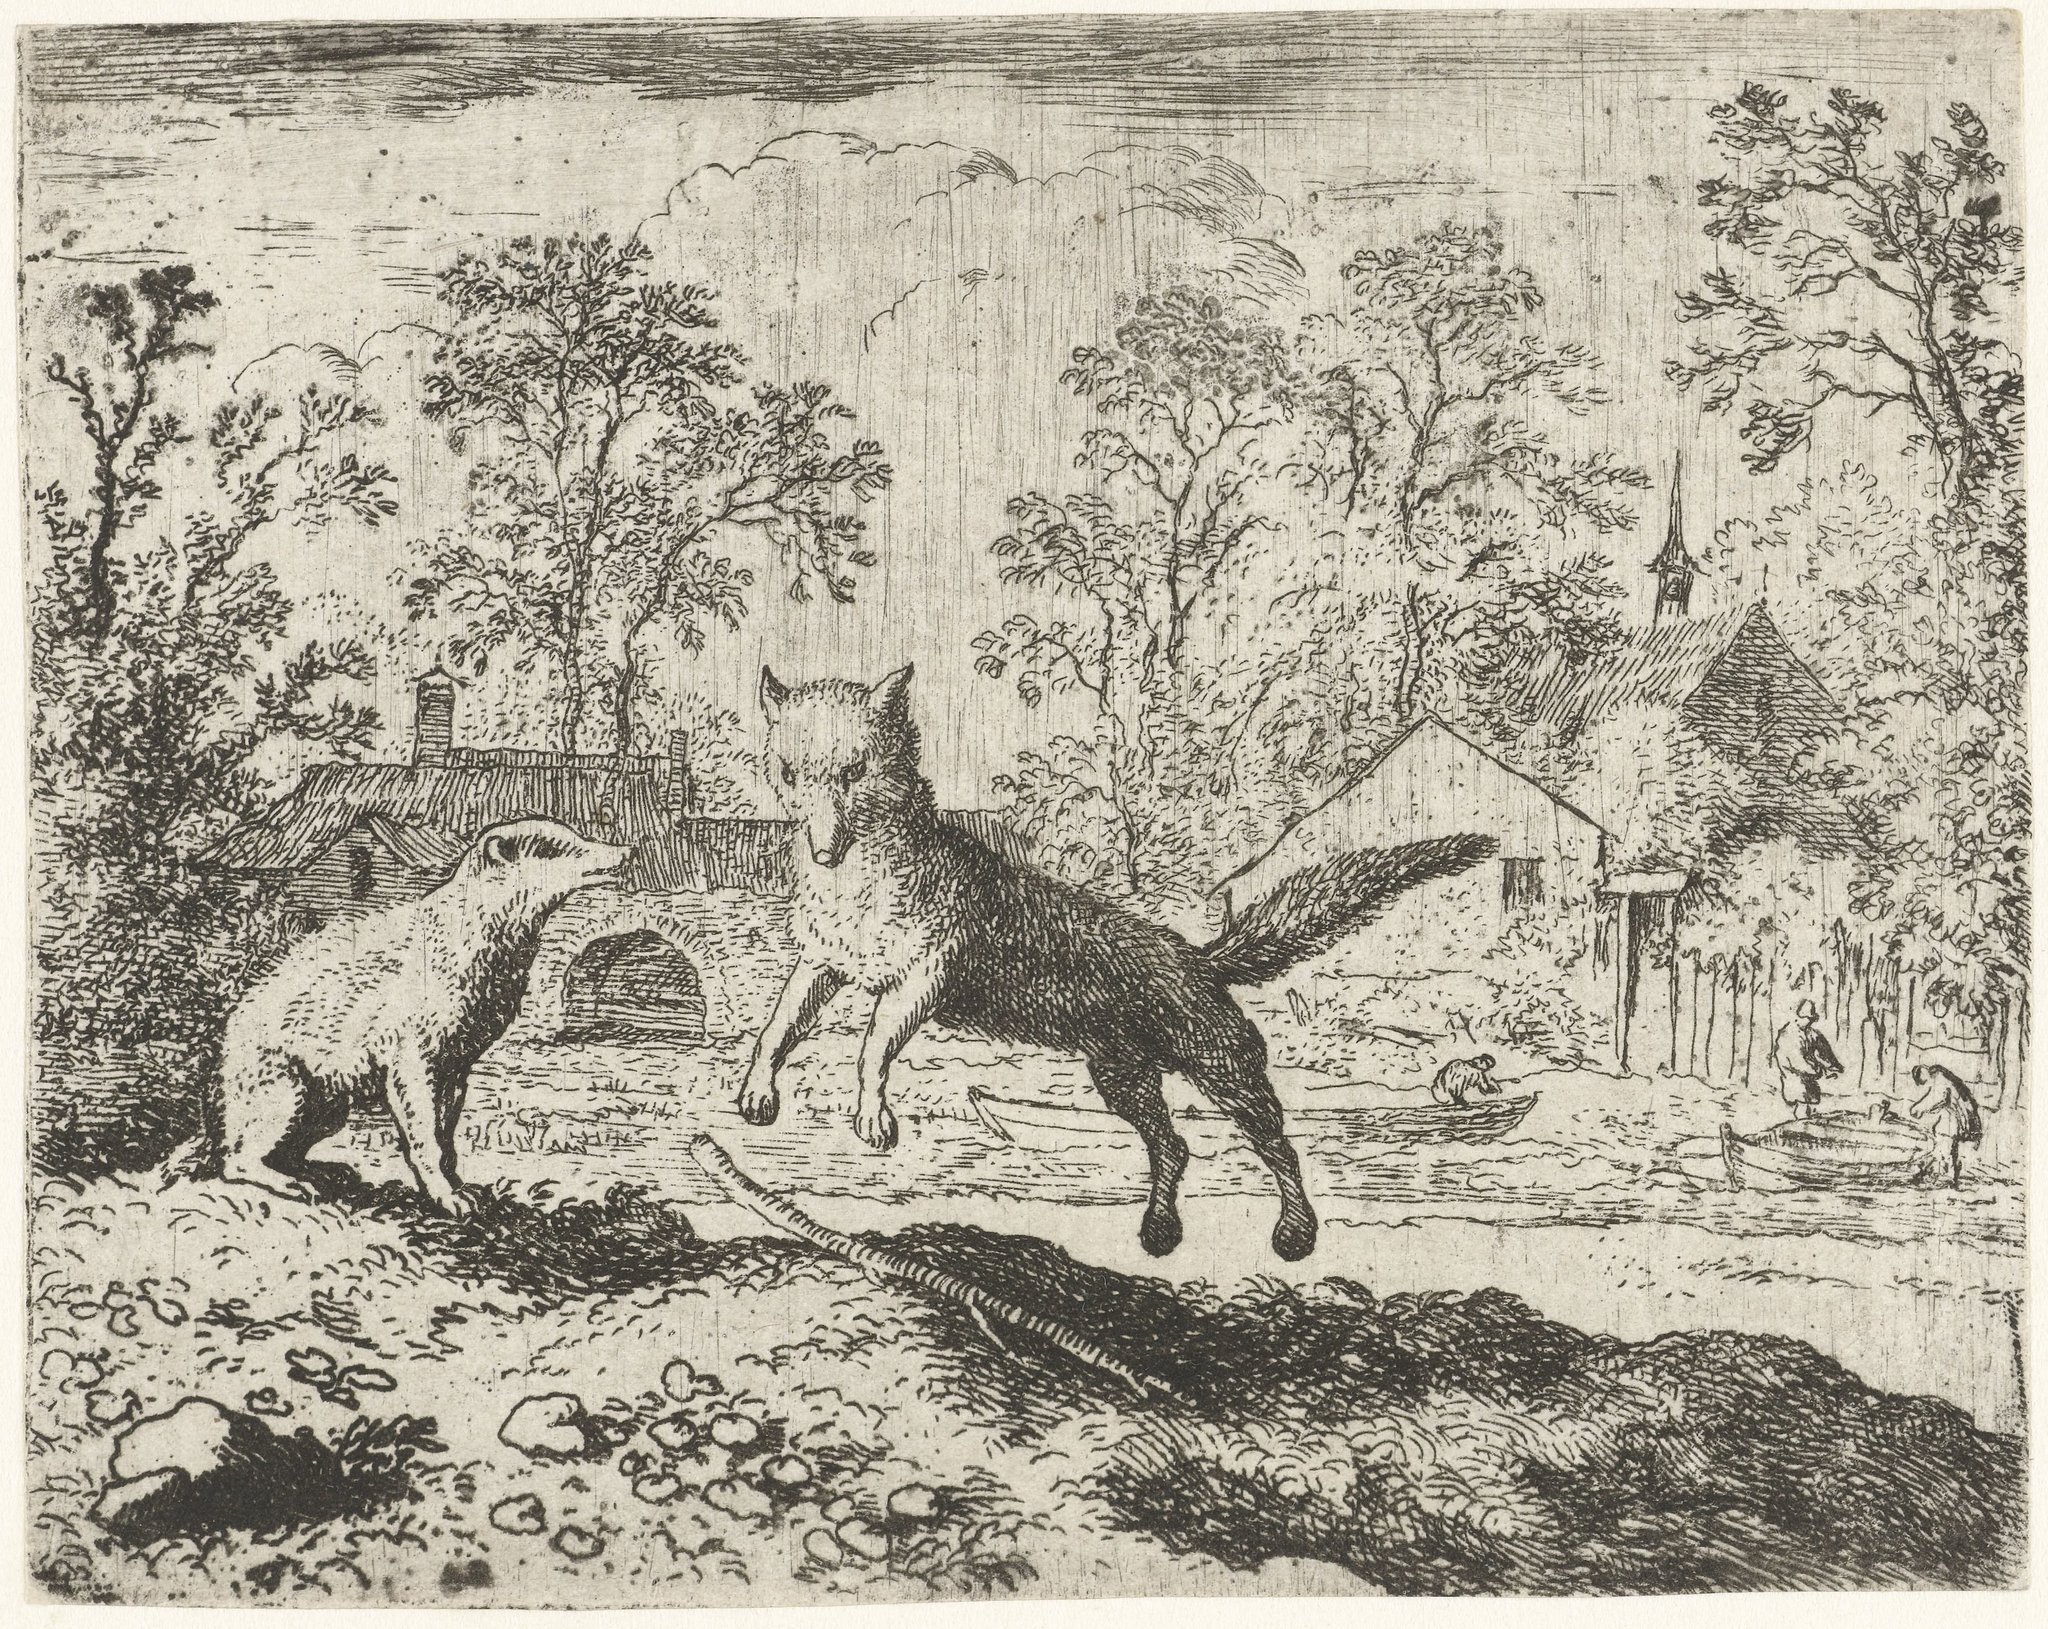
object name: print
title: Reinaert de vos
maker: allaert van everdingen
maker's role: draughtsman, painter, print maker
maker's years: 1621-1675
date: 1665-1675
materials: paper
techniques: etching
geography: netherlands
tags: fable of reynard the fox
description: Reinaert de vos en Grinbeert de das aan de oever van een rivier. Op de achtergrond een dorp en drie personen bij roeiboten.